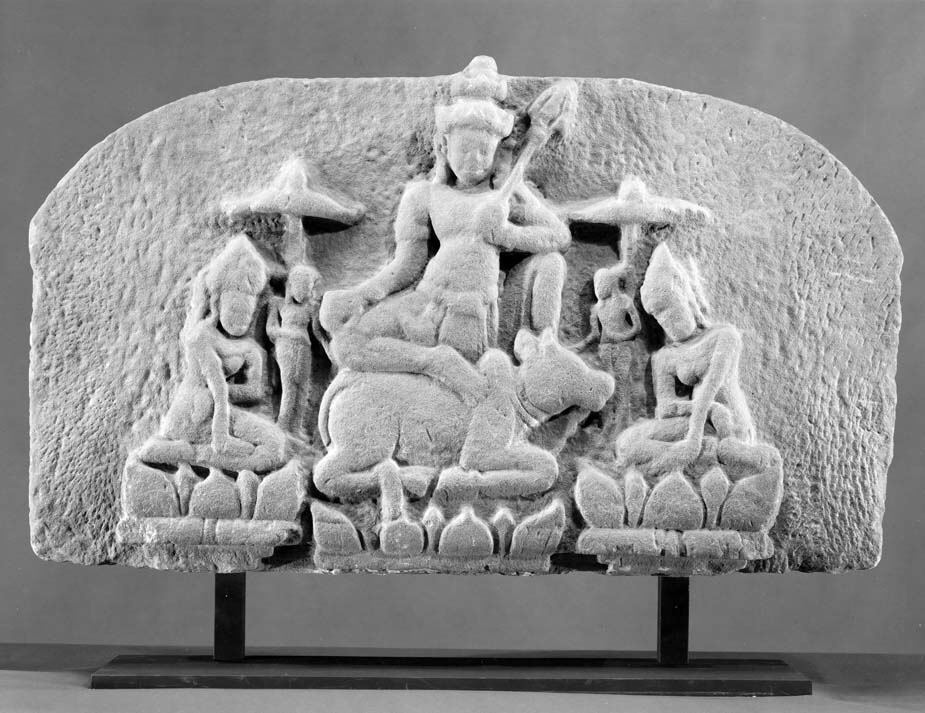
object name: figure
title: Shiva Seated on Nandi, Flanked by Consorts (Tympanum)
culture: vietnamese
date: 901-950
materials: stone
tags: animals,shiva